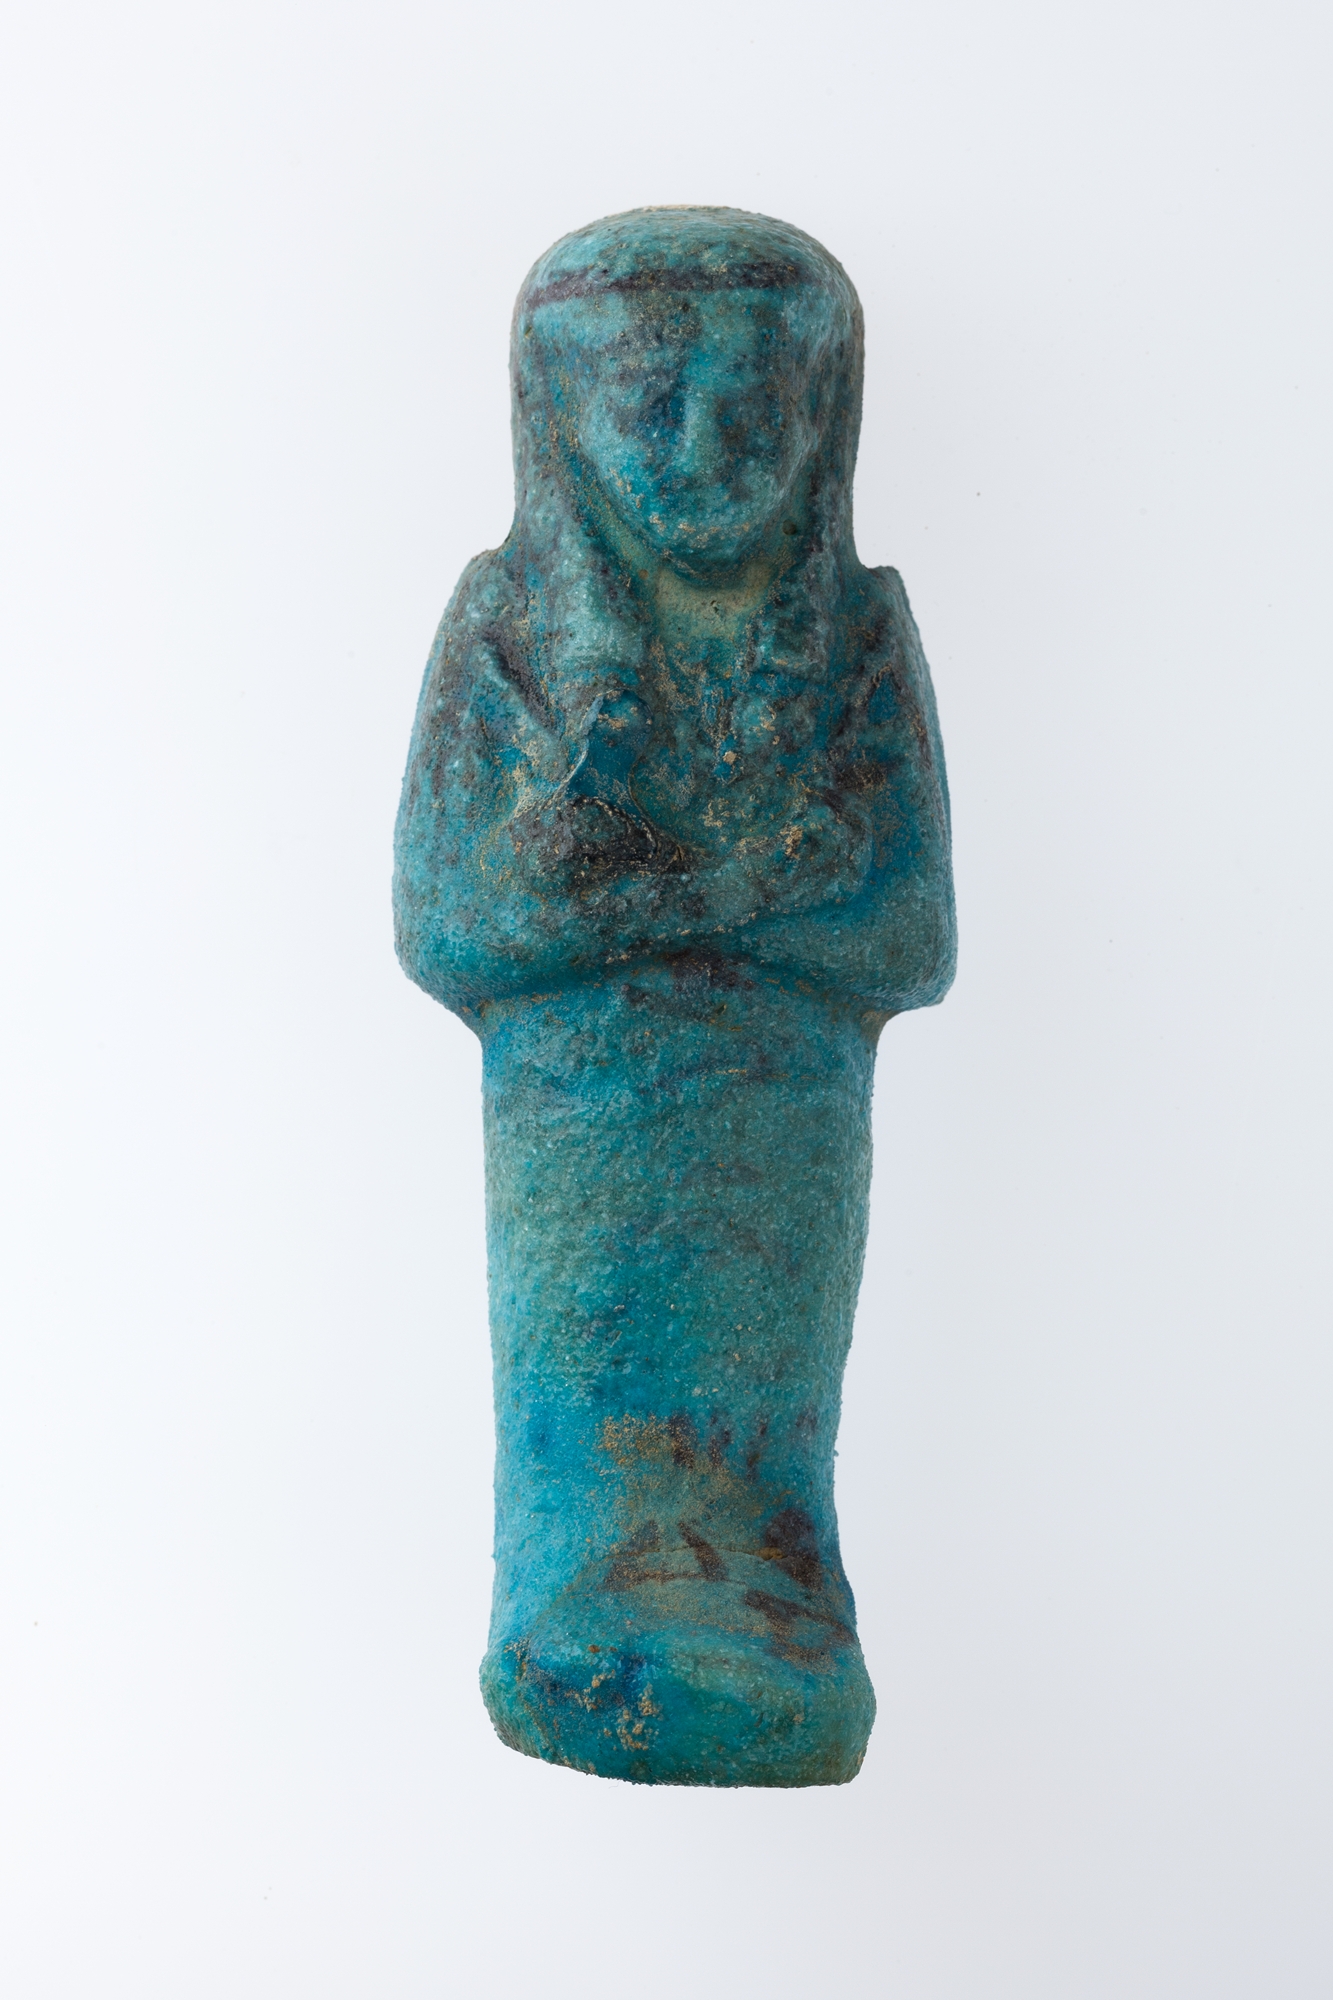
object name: shabti, henettawy c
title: Worker Shabti of Henettawy (C), Daughter of Isetemkheb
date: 990-970 BCE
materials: faience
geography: egypt